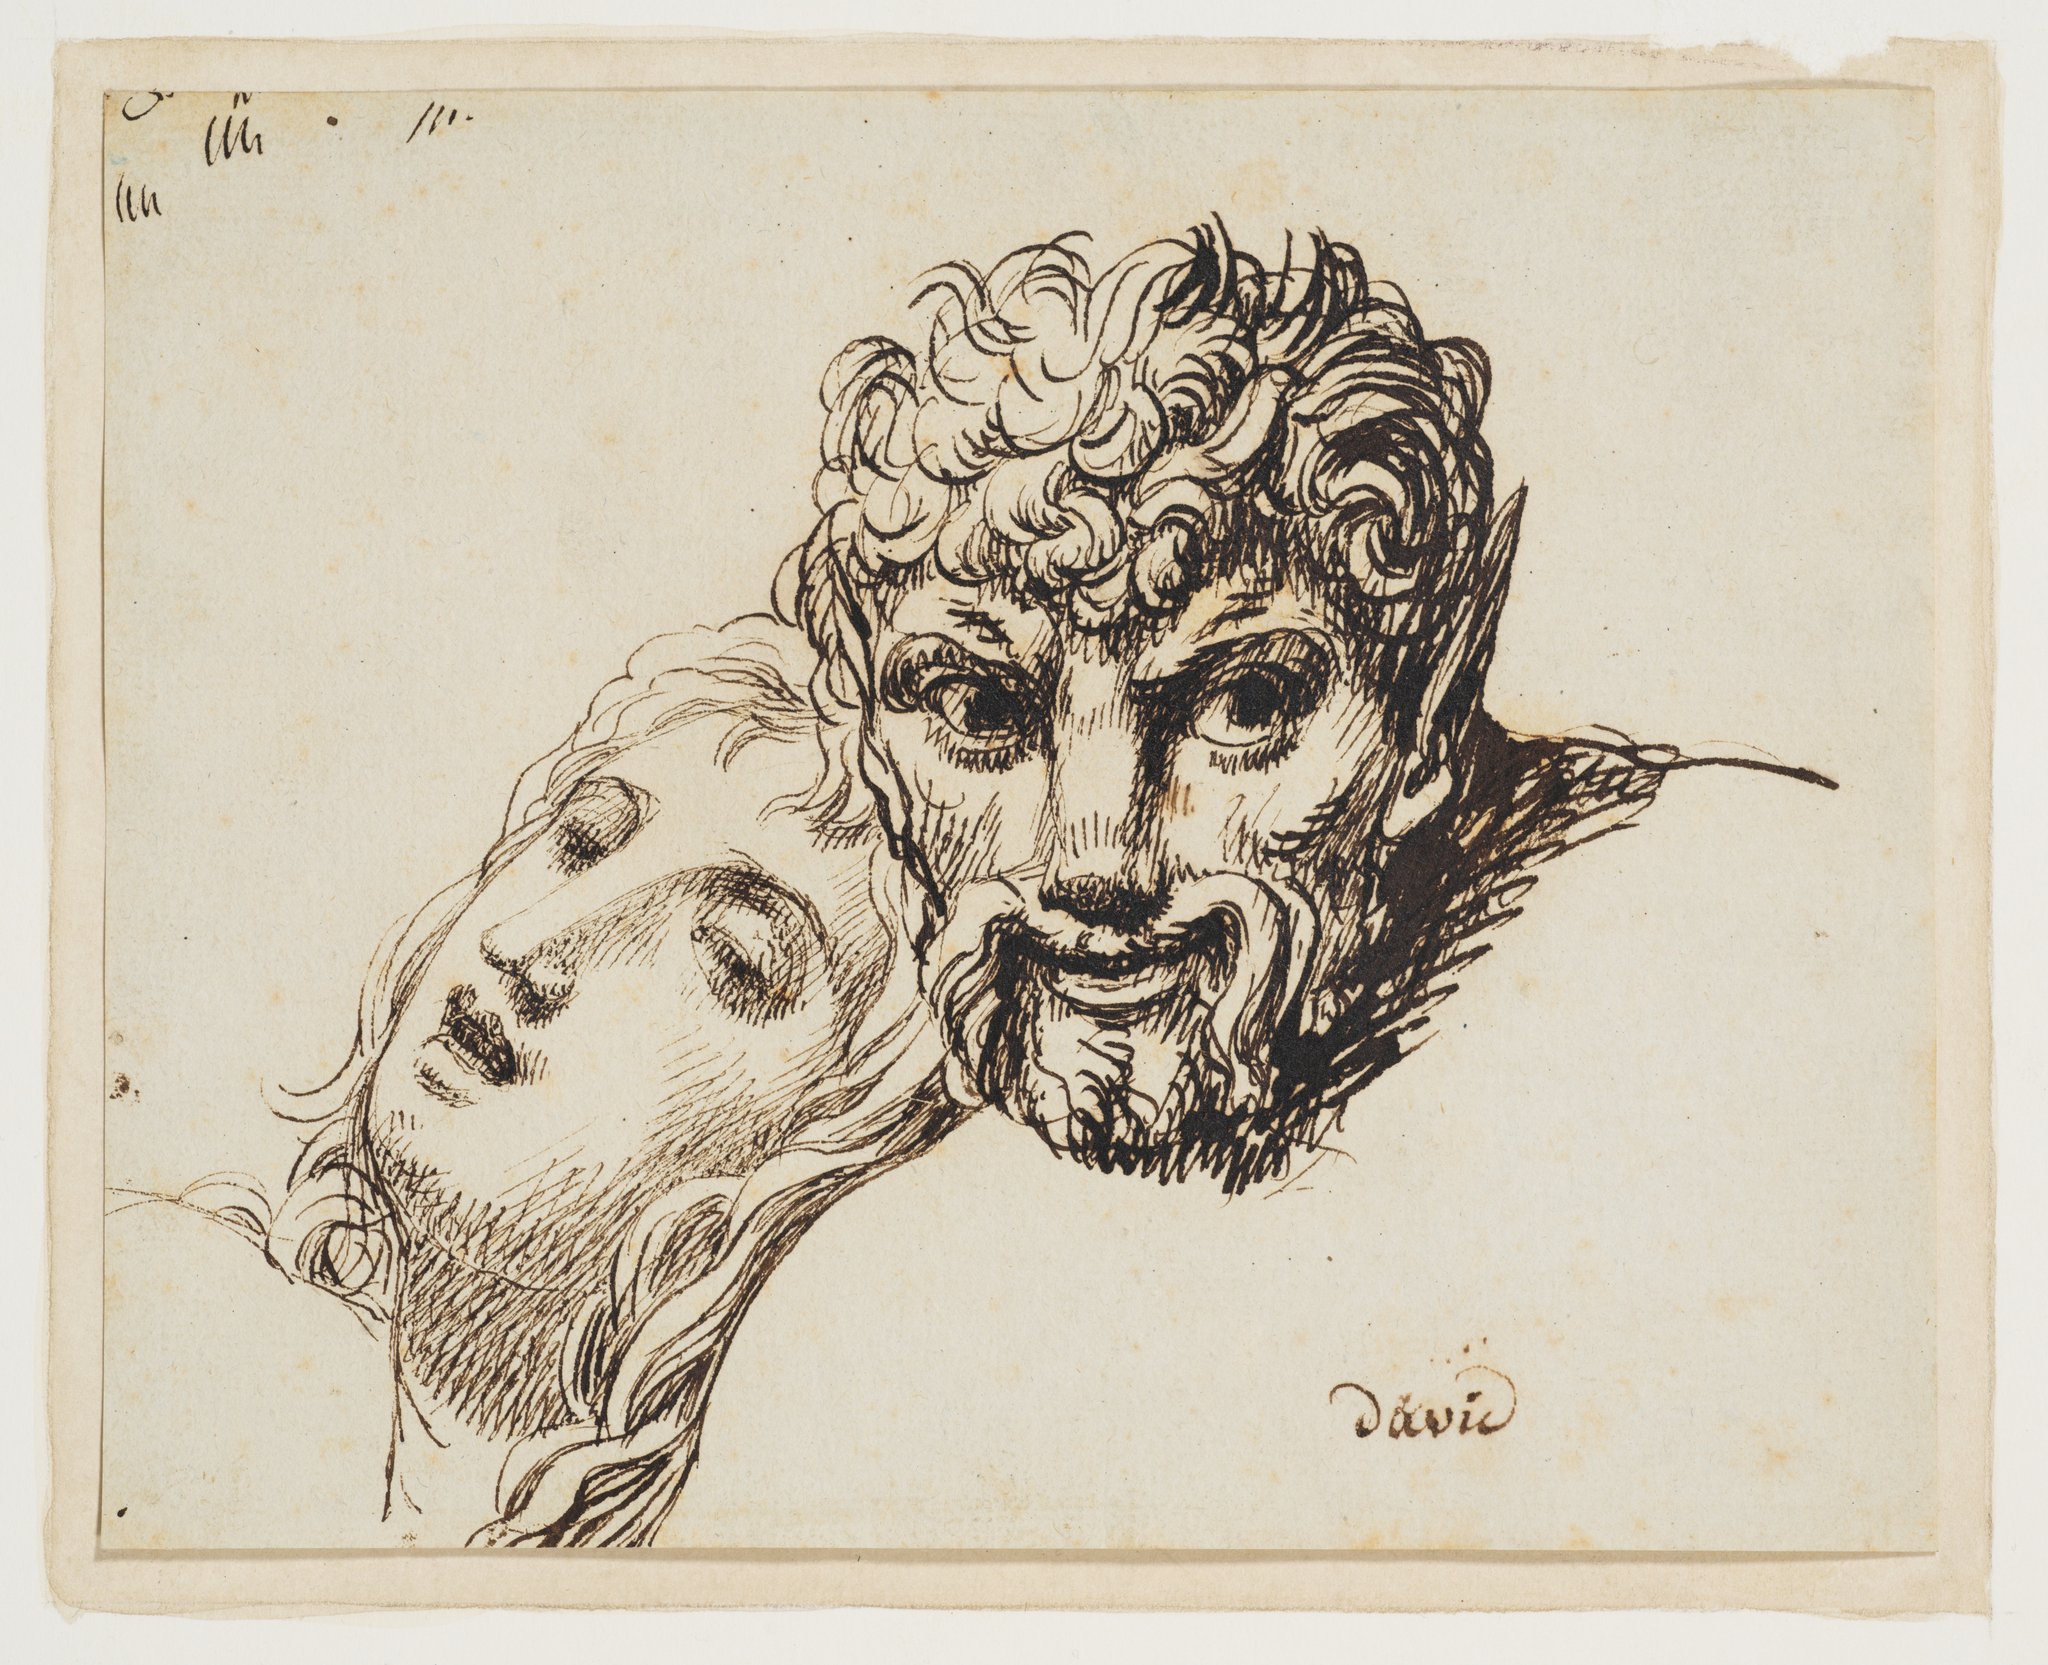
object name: drawing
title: Heads of a faun and a reclining woman (Les têtes d'une jeune femme et d'un faune)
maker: jacques louis david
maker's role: artist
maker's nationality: french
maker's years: 1748-1825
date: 1792-1796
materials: ink, iron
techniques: pen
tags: heads,women,fauns